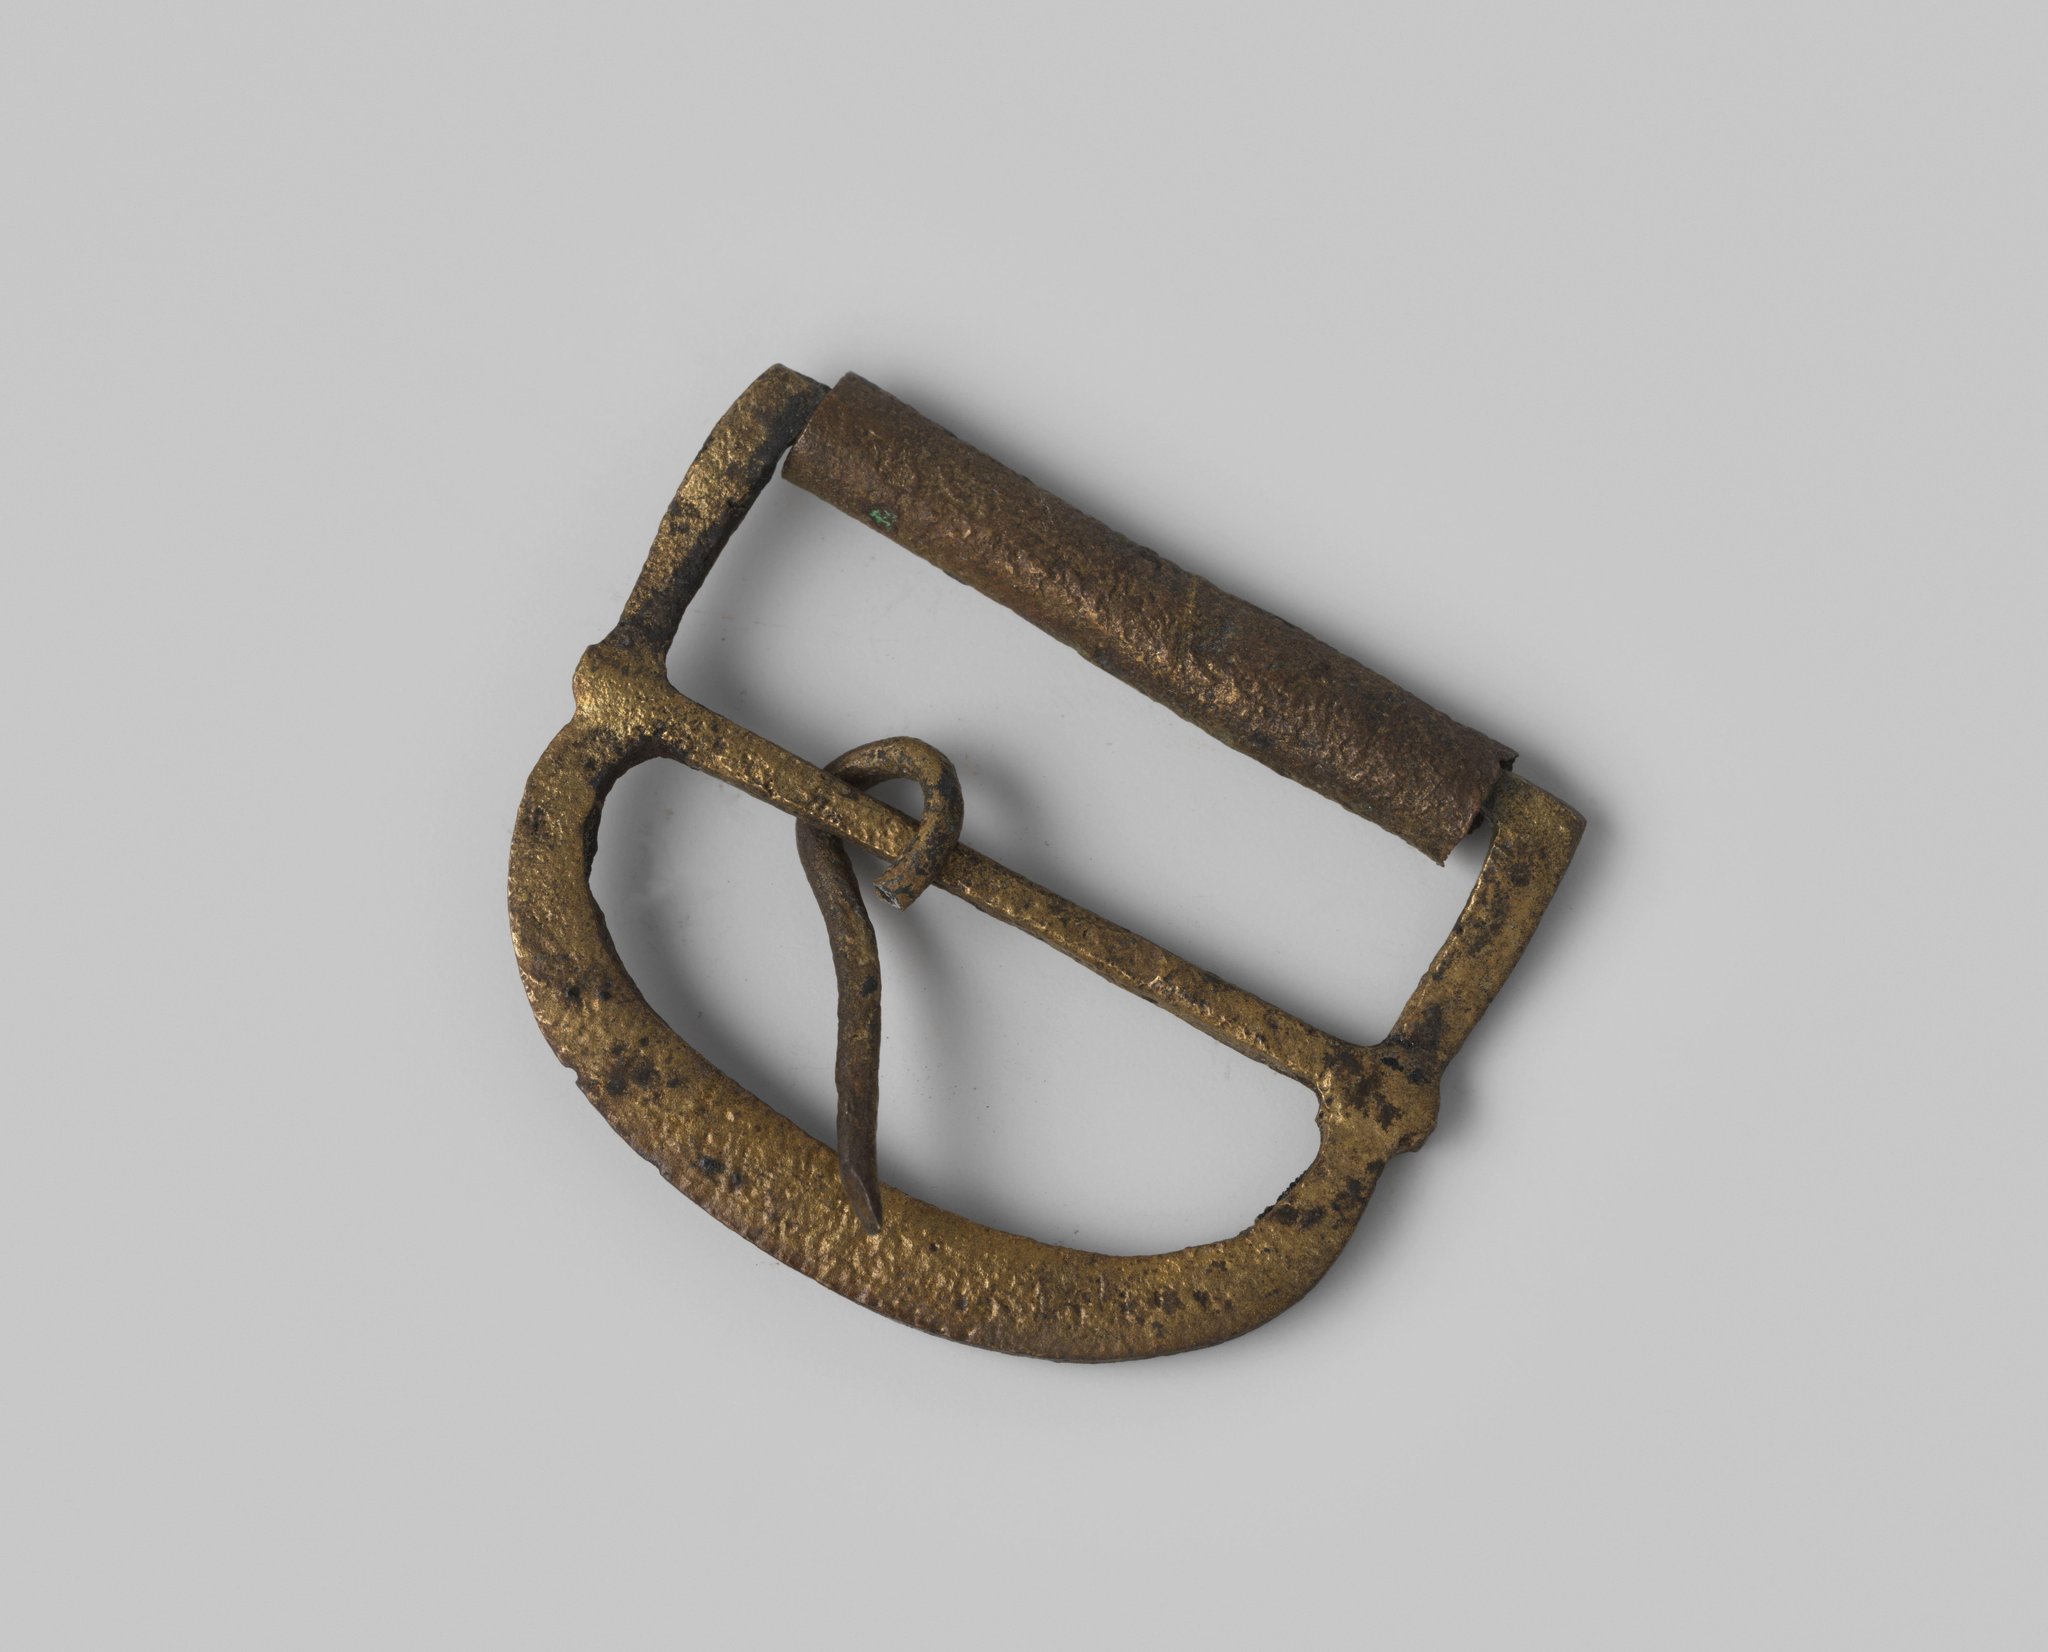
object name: belt buckle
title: Riemgesp uit het wrak van de Oost-Indiëvaarder Hollandia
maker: Anonymous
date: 1700-1743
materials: copper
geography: netherlands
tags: verenigde oostindische compagnie, hollandia (schip), annet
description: D-shaped, ring with spindle and tongue, cylindrical case around straight side, belt buckle.